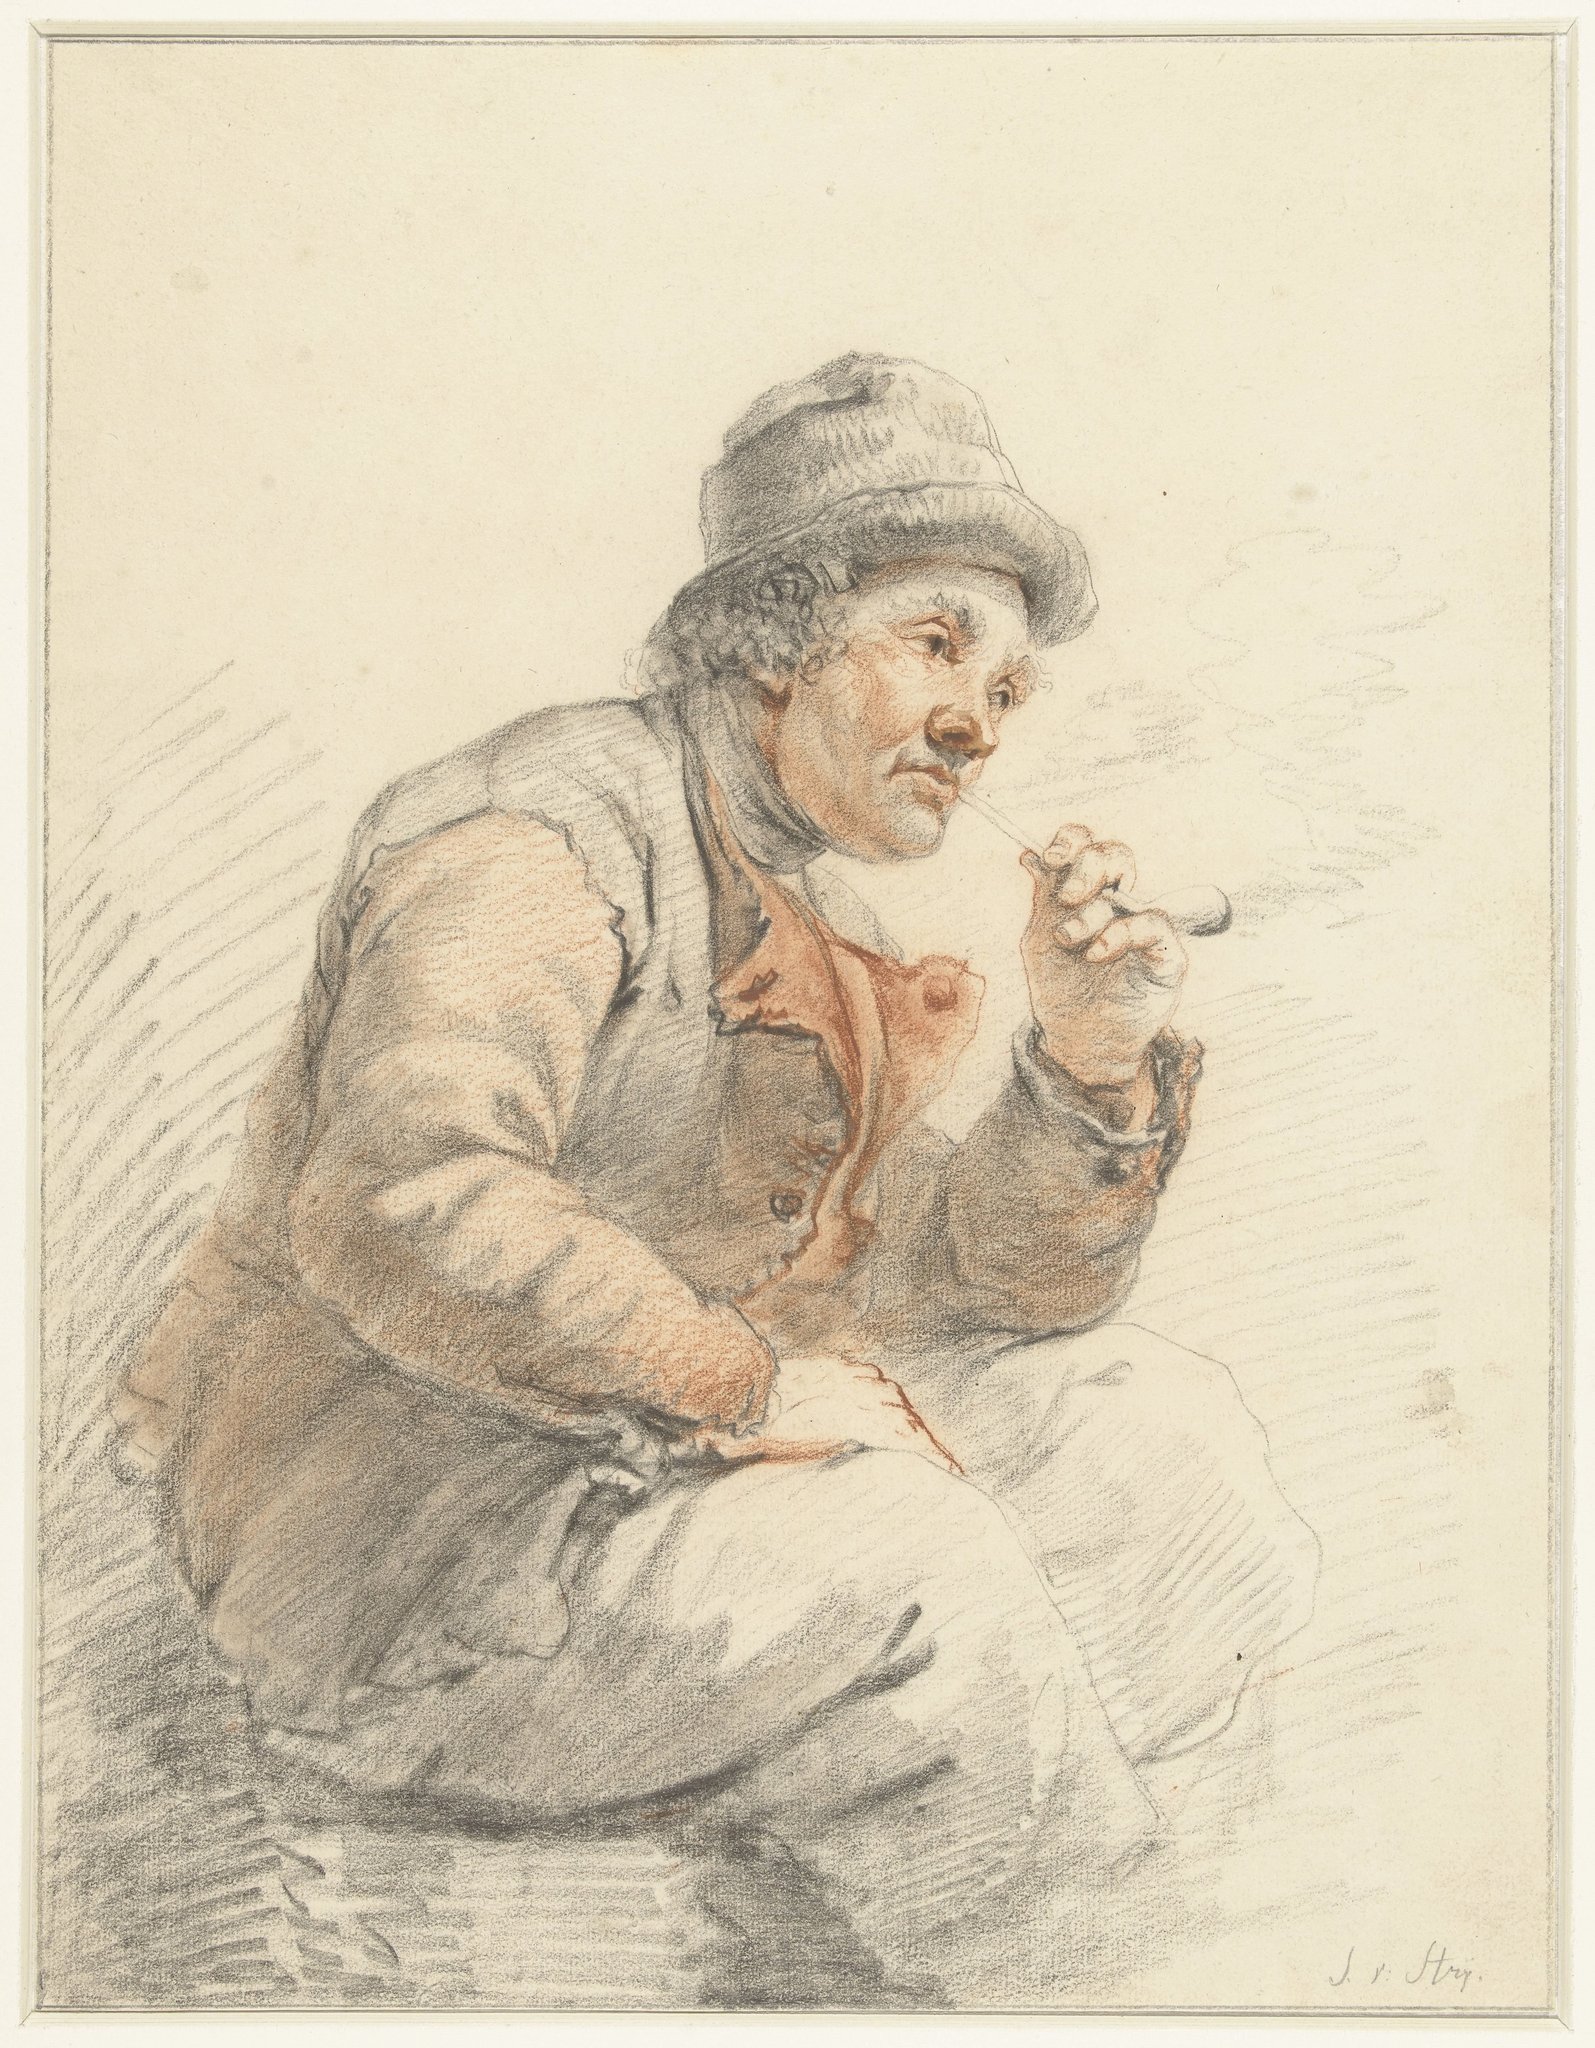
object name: drawing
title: Zittende, pijprokende boer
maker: jacob van strij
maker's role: draughtsman, painter, print maker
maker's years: 1756-1815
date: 1766-1815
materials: chalk, paper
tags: tobacco (+ taking (particular) foodstuffs: eating, drinking, smoking, chewing, etc.)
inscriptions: signature: ‘J: v: Strij’